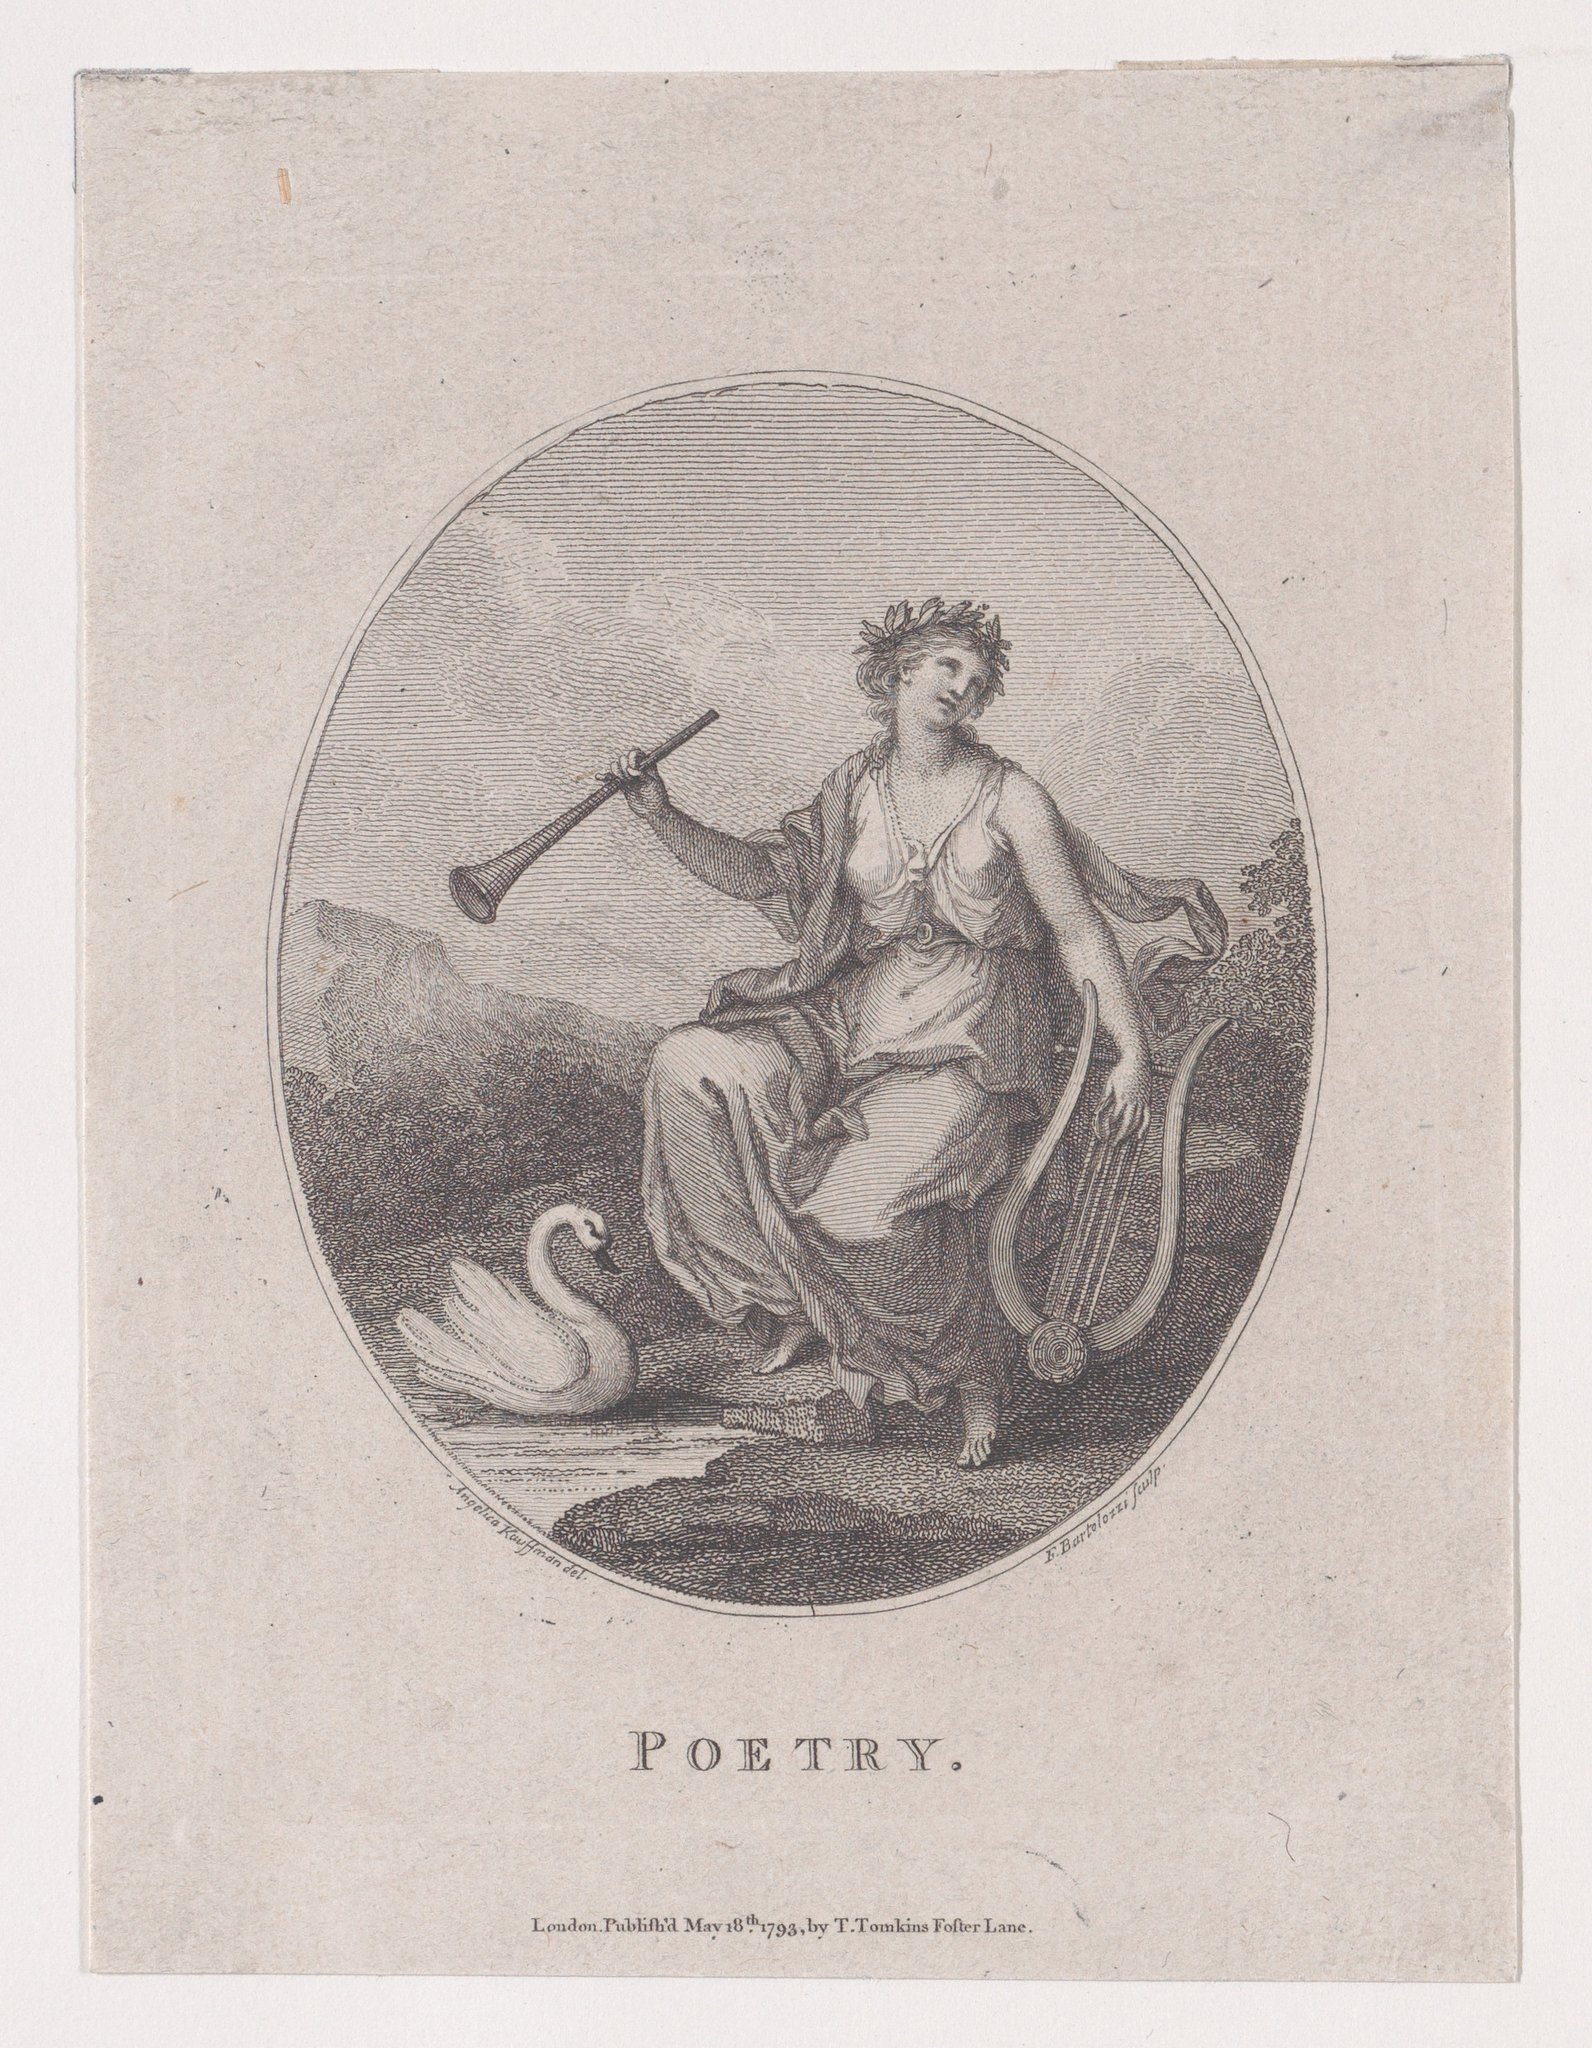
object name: print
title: Poetry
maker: francesco bartolozzi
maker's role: artist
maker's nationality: italian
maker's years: 1728-1815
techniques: engraving, etching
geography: england